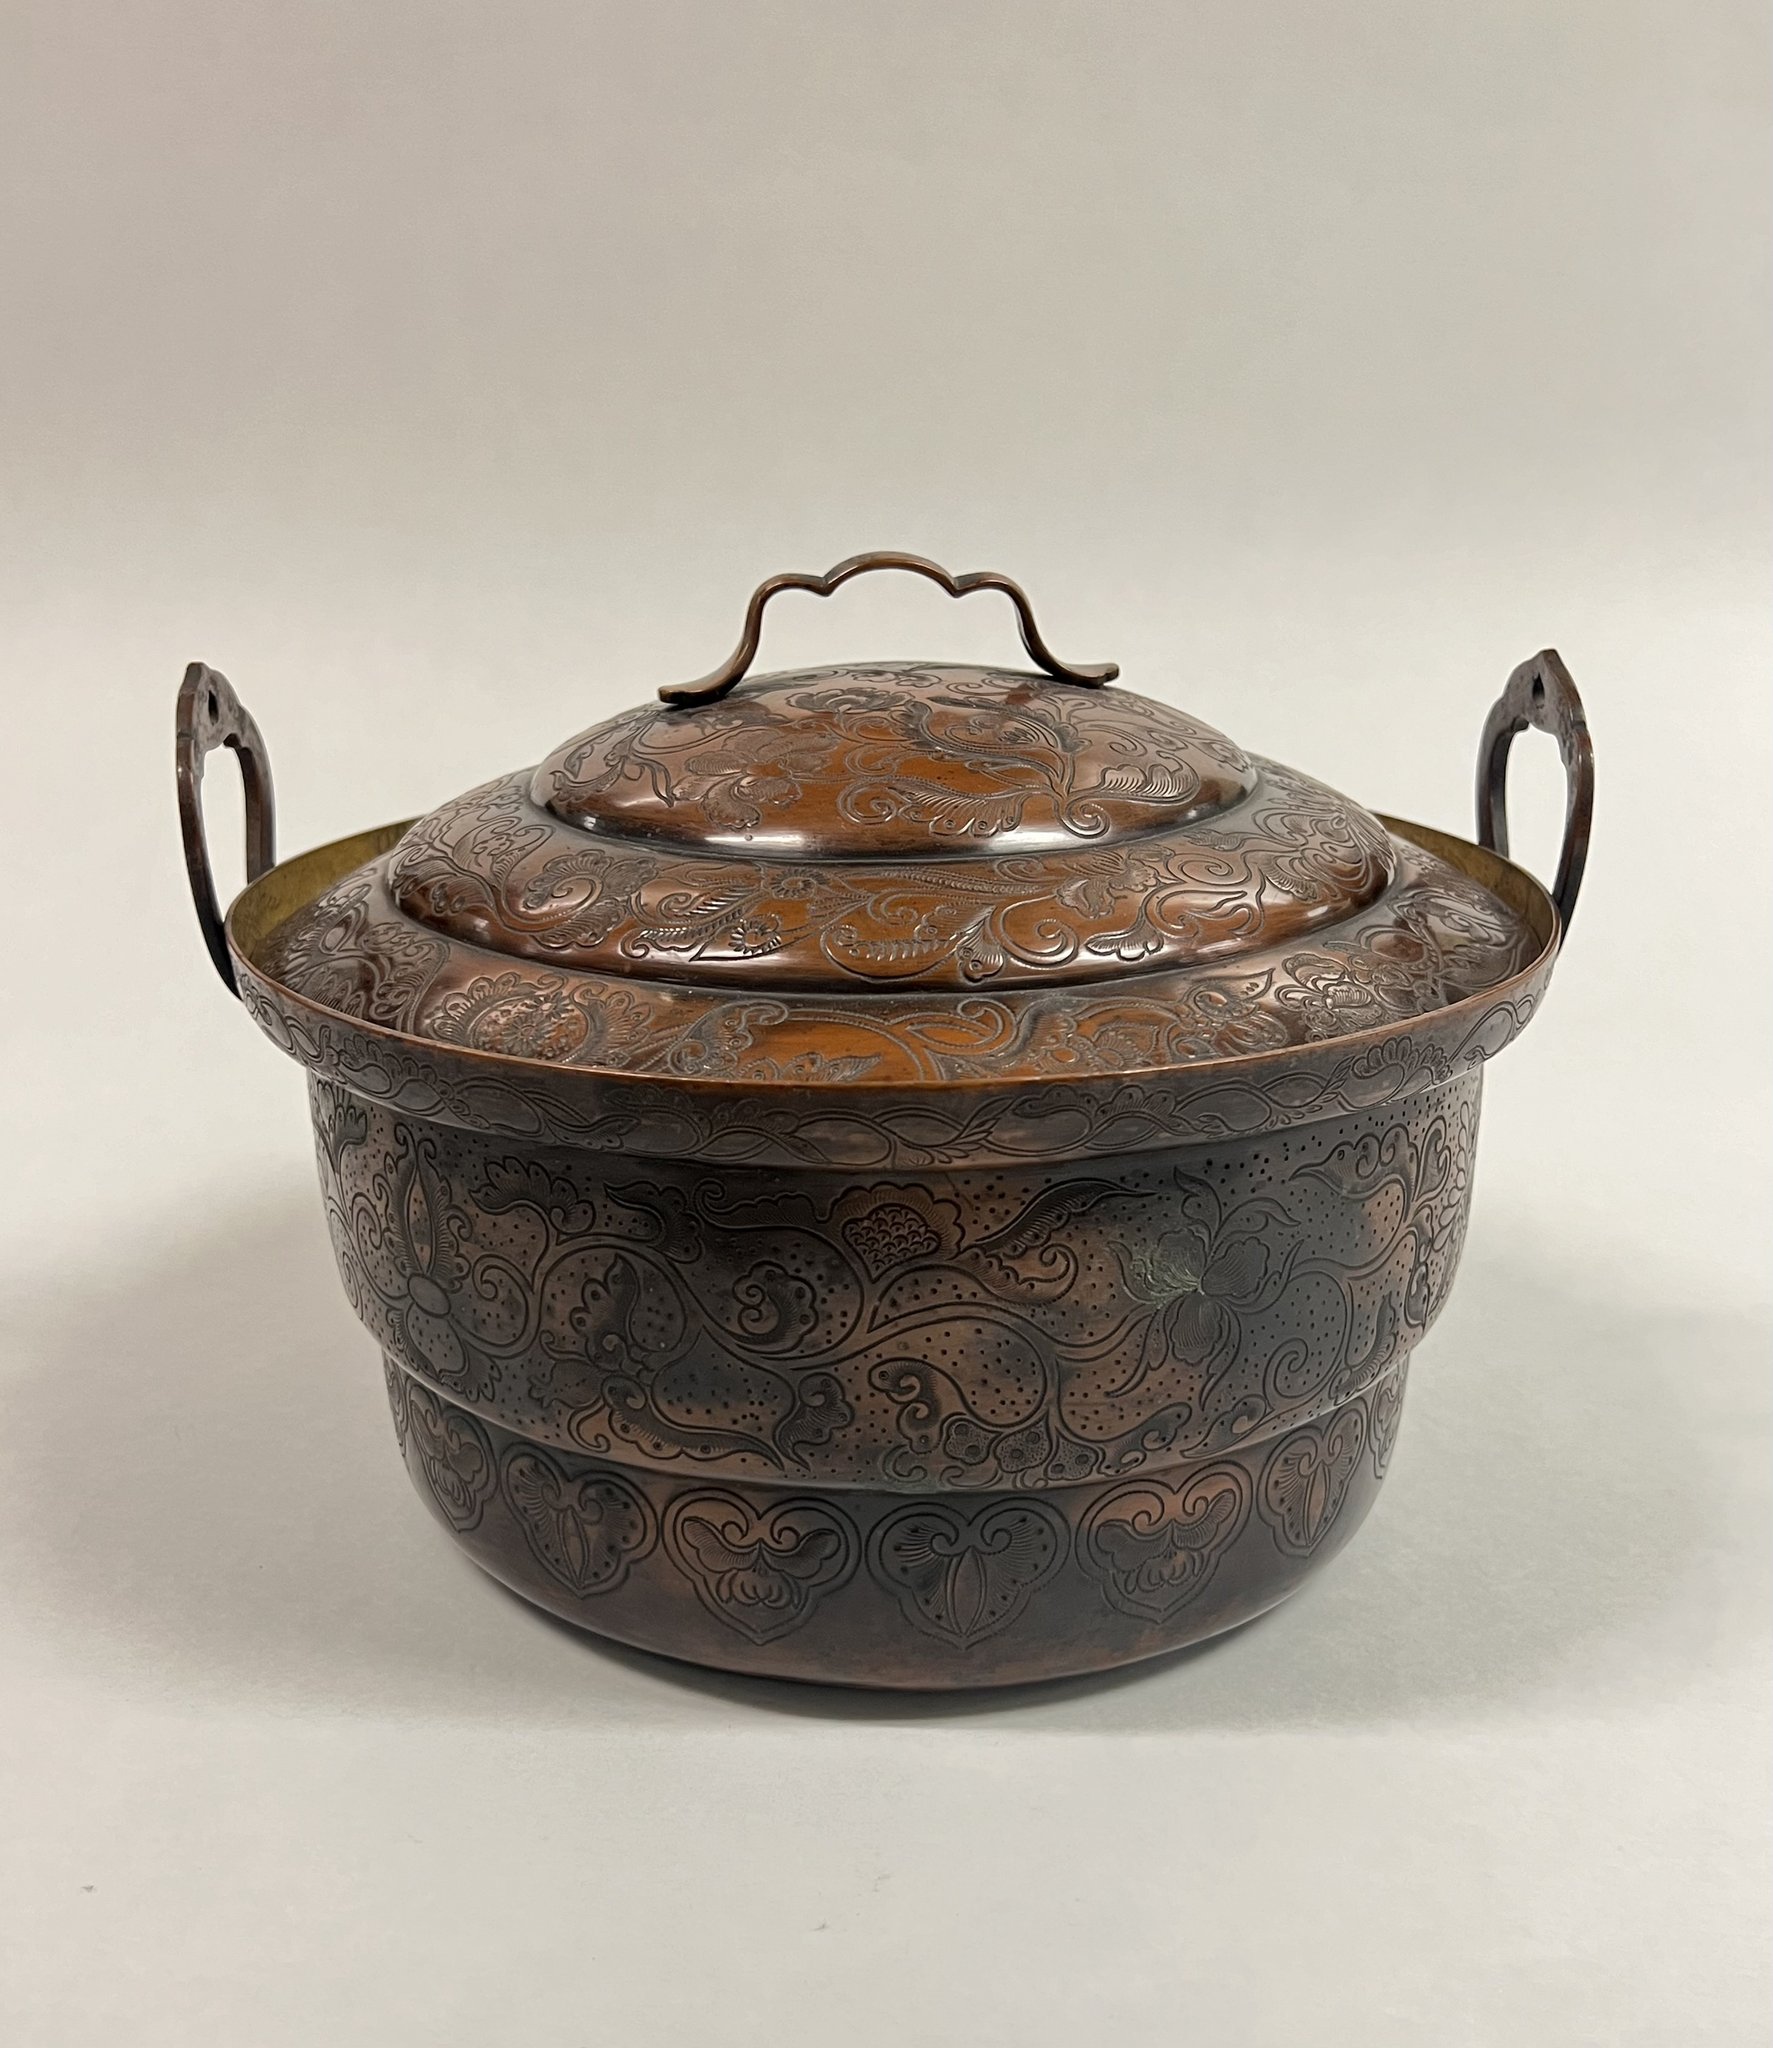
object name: covered pan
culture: japanese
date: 1701-1800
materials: bronze